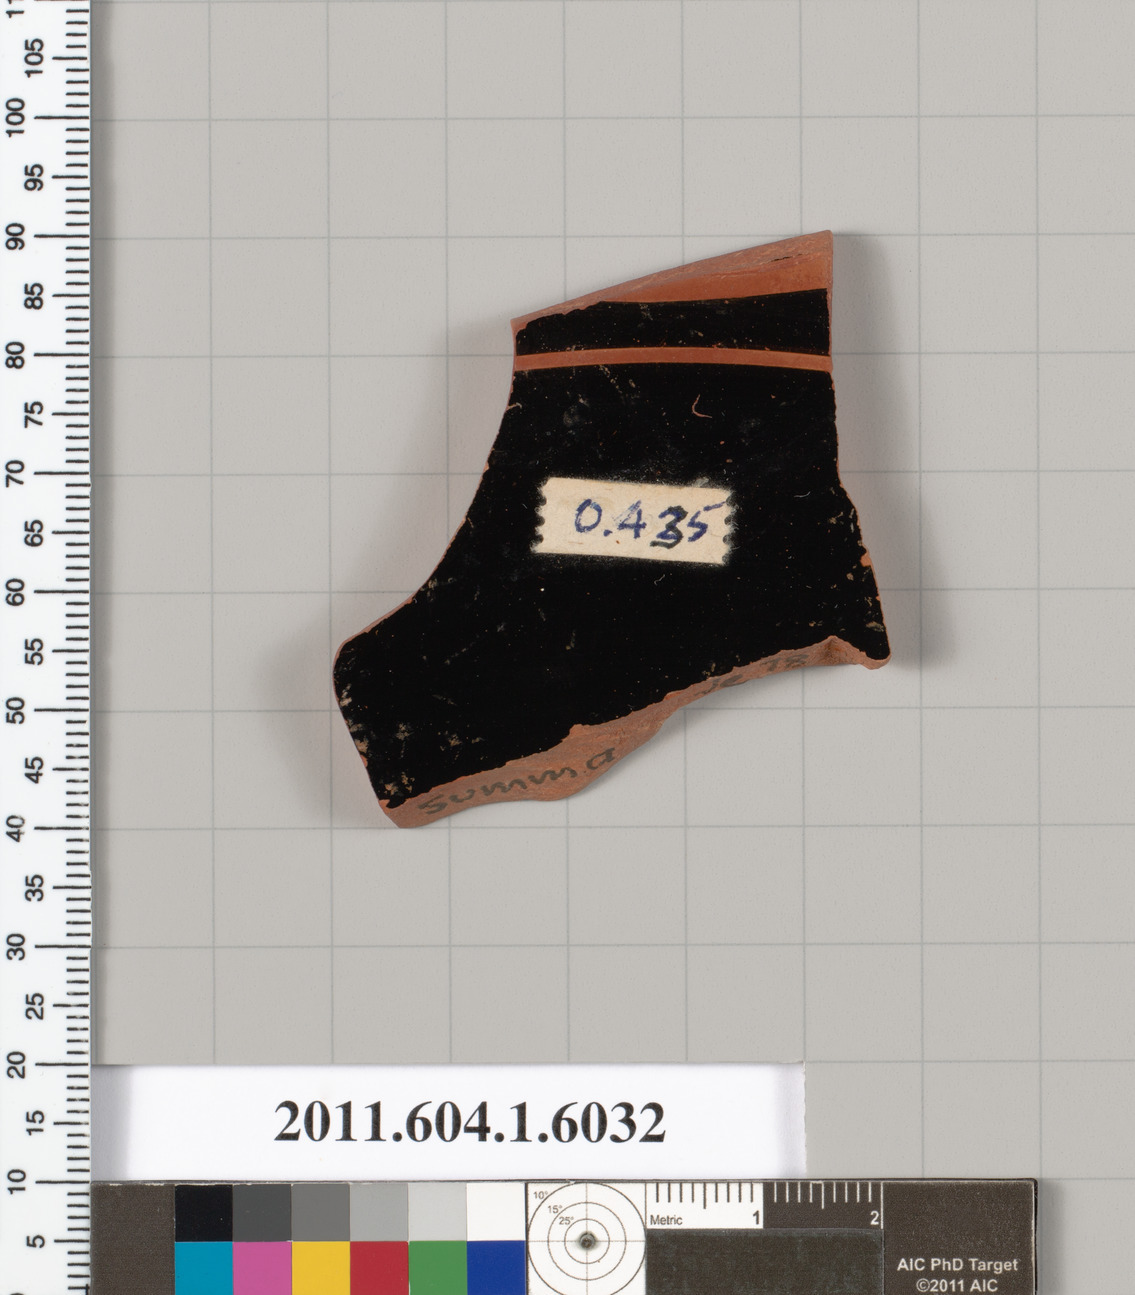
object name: kylix fragment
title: Terracotta fragment of a kylix (drinking cup)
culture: greek, attic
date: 510-500 BCE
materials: terracotta